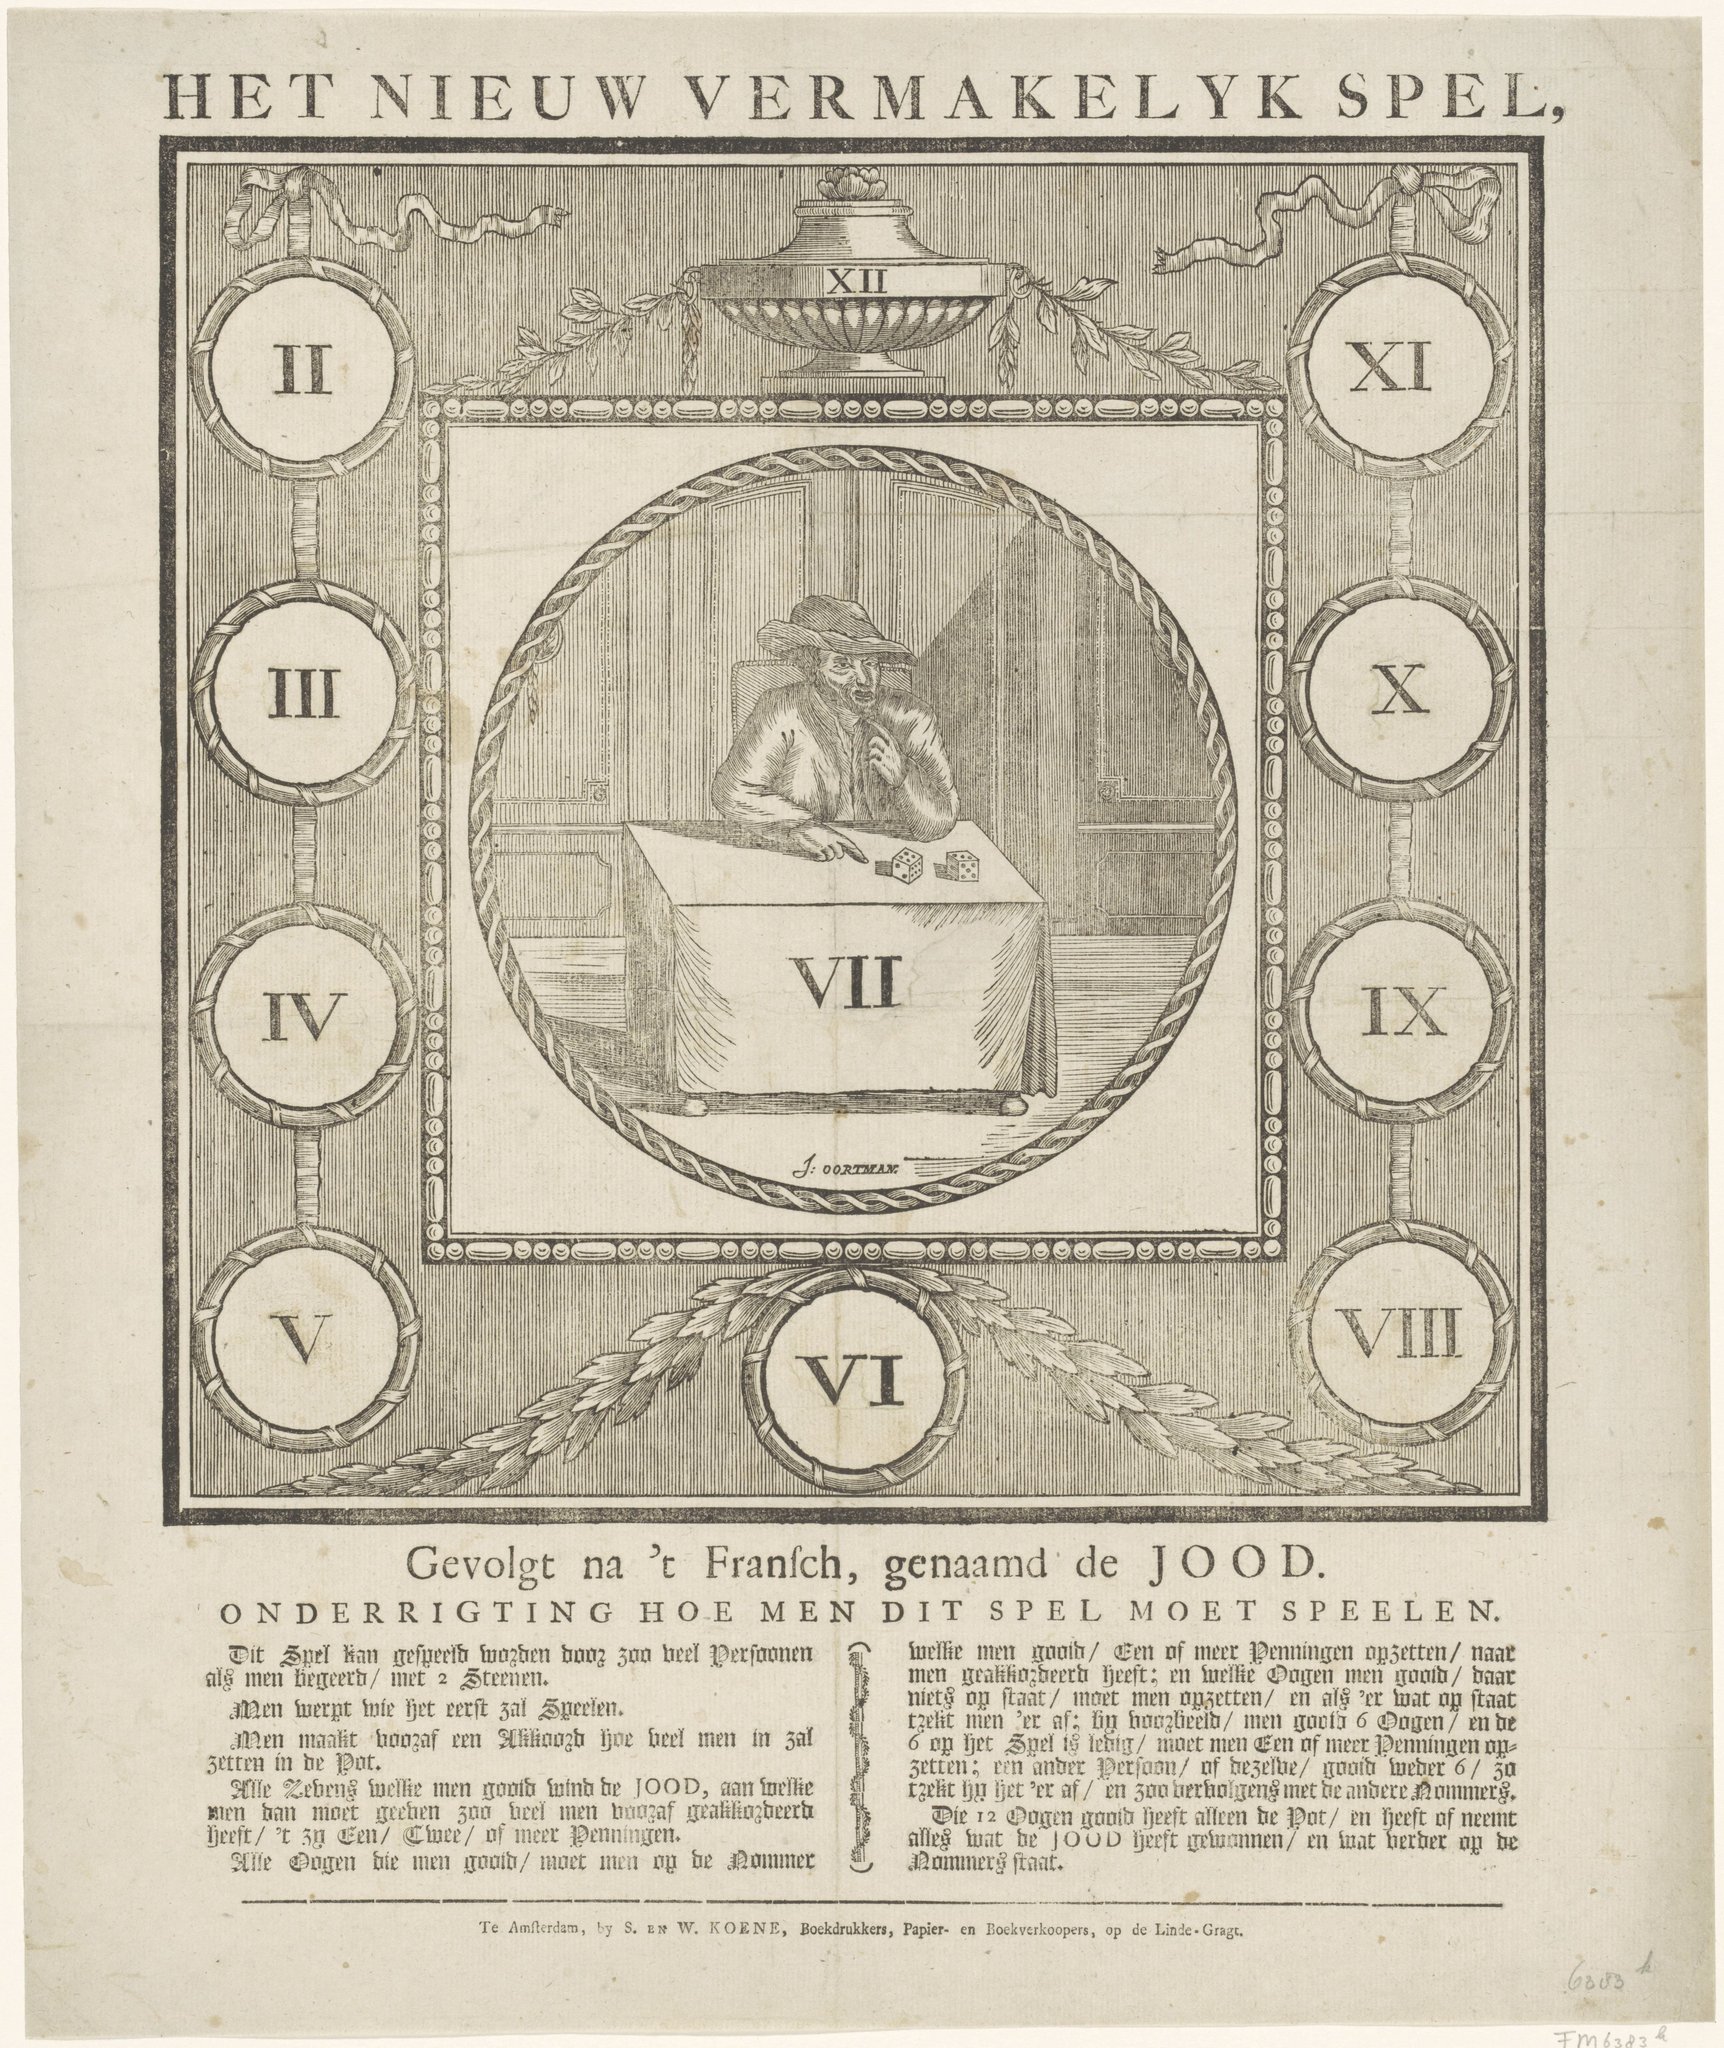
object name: print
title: Bordspel genaamd 'De Jood', ca. 1800-1810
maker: jan oortman (sr.)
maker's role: print maker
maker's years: 1753-1823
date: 1800-1810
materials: paper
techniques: letterpress printing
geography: netherlands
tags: board-games of chance, anti-semitism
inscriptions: collector's mark: Lugt 2228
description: Jodenspel of bordspel genaamd 'De Jood' met centraal een afbeelding van een zittende joodse man achter een tafel waarop twee dobbelstenen, met negen vakjes met Romeinse cijfers. Onderaan de spelregels. Onderdeel van een groep van kinder- en gezelschapsspelen gedrukt in de periode ca. 1750-1850.